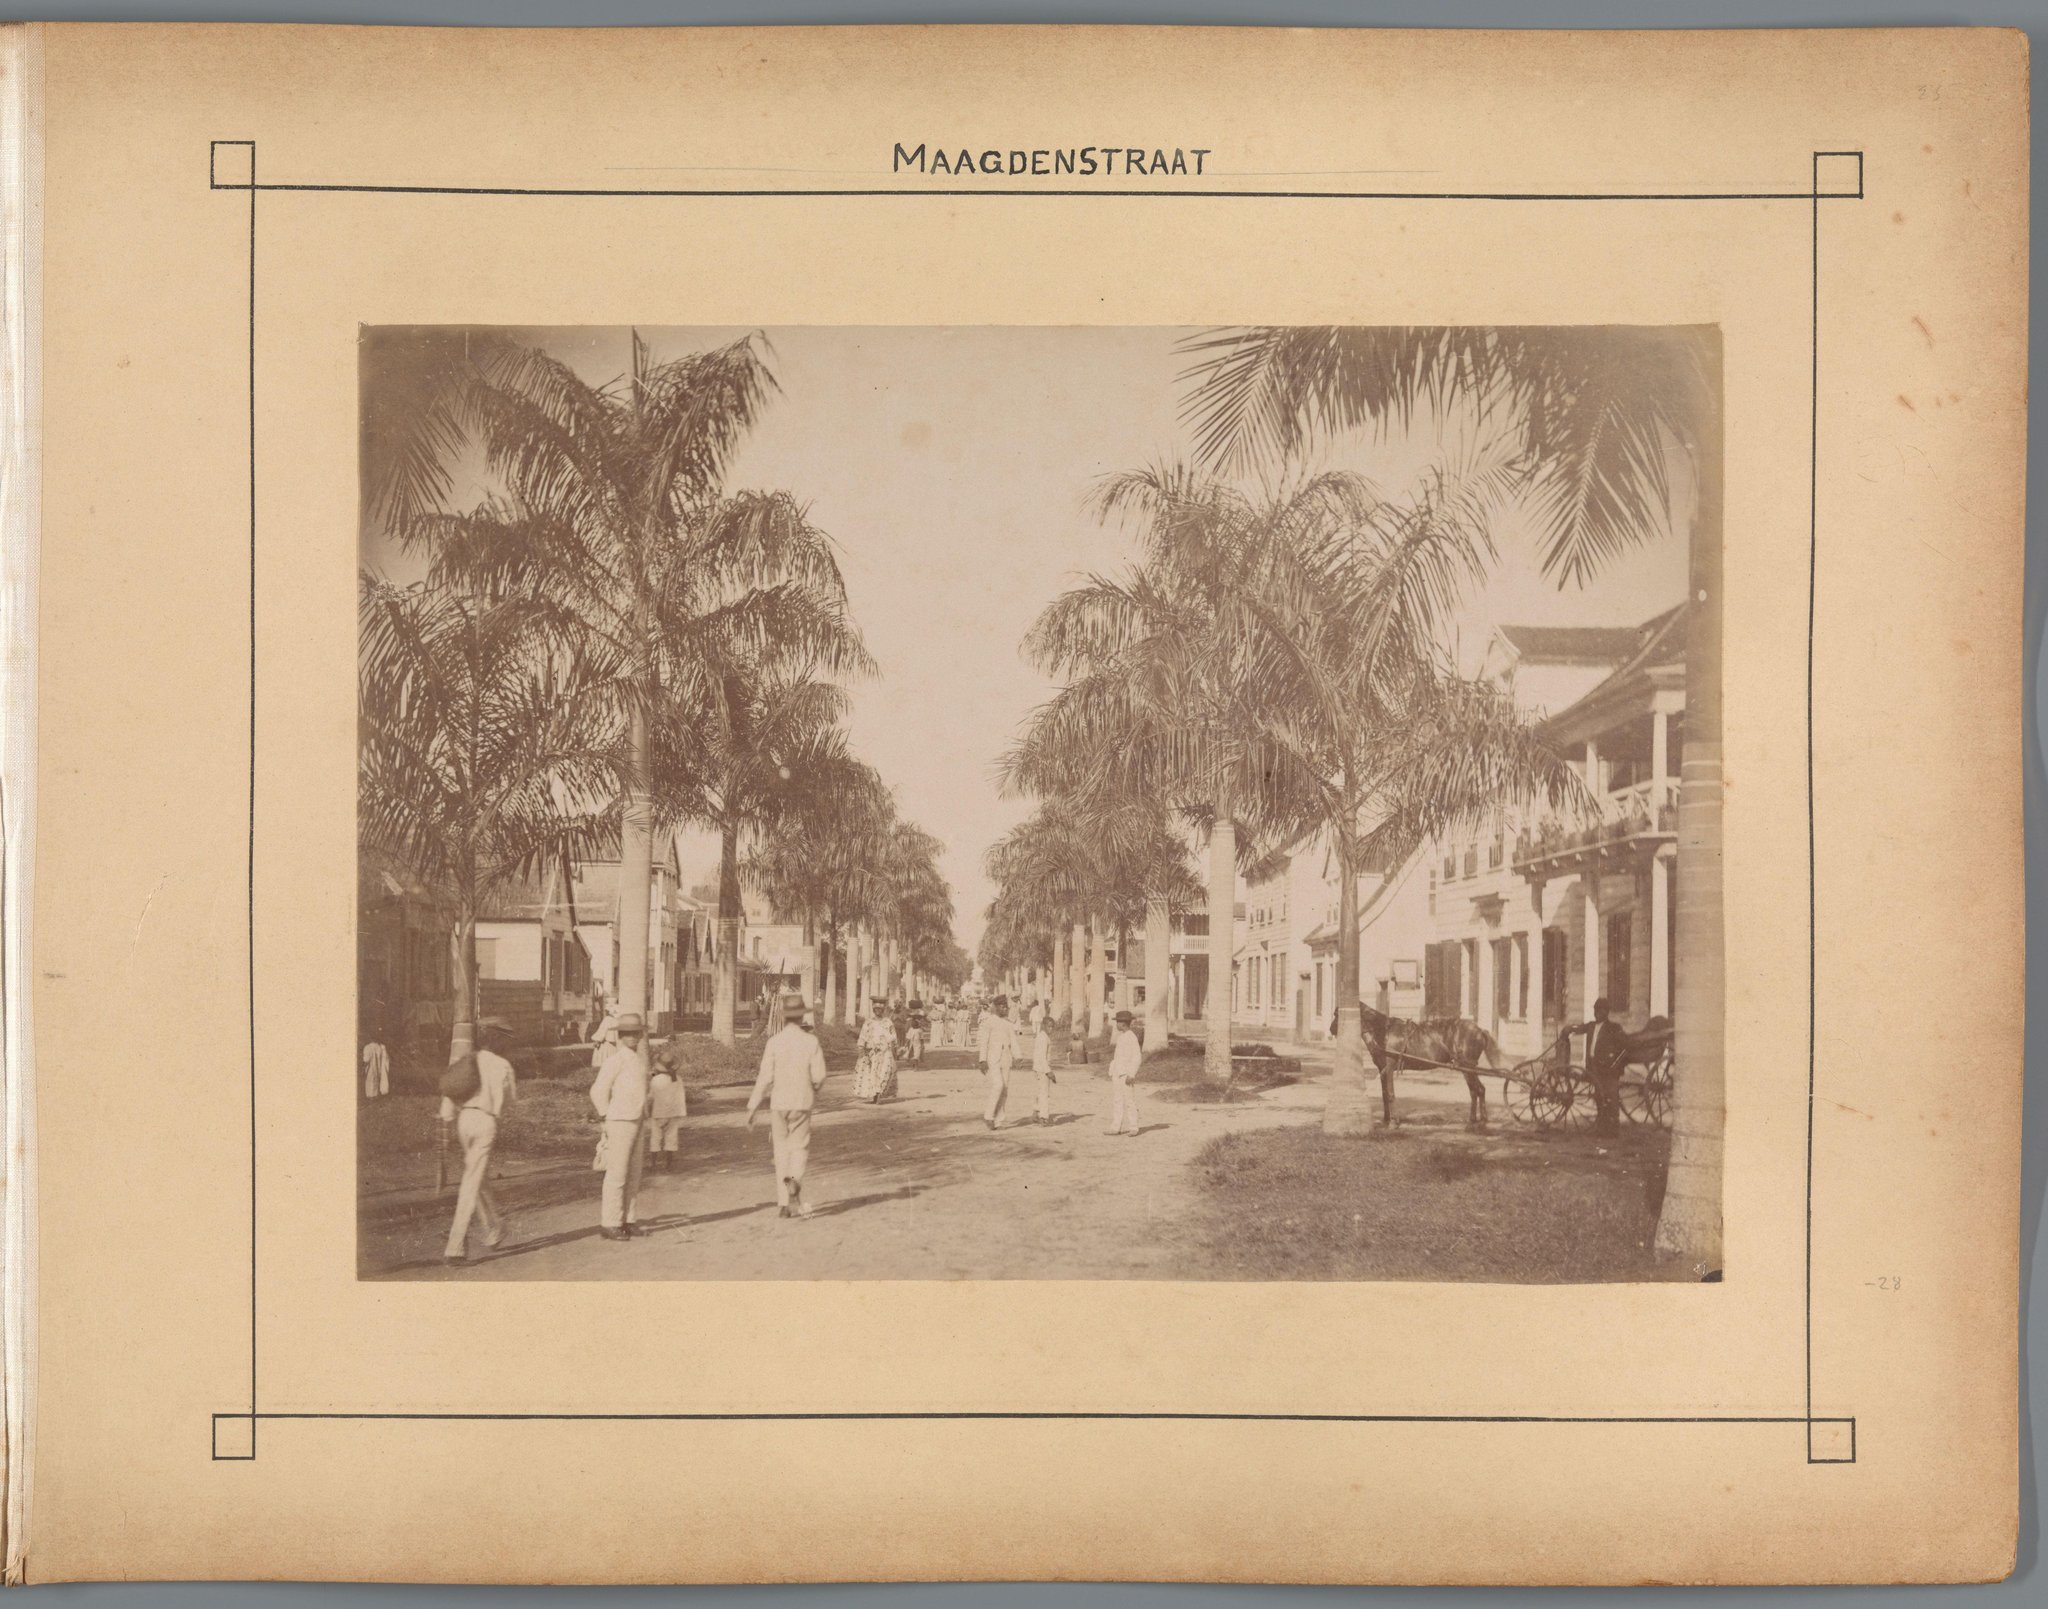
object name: photograph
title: Maagdenstraat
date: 1898-1902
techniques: albumen print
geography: suriname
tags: street, suriname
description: Gezicht in de Maagdenstraat geflankeerd door koningspalmen.